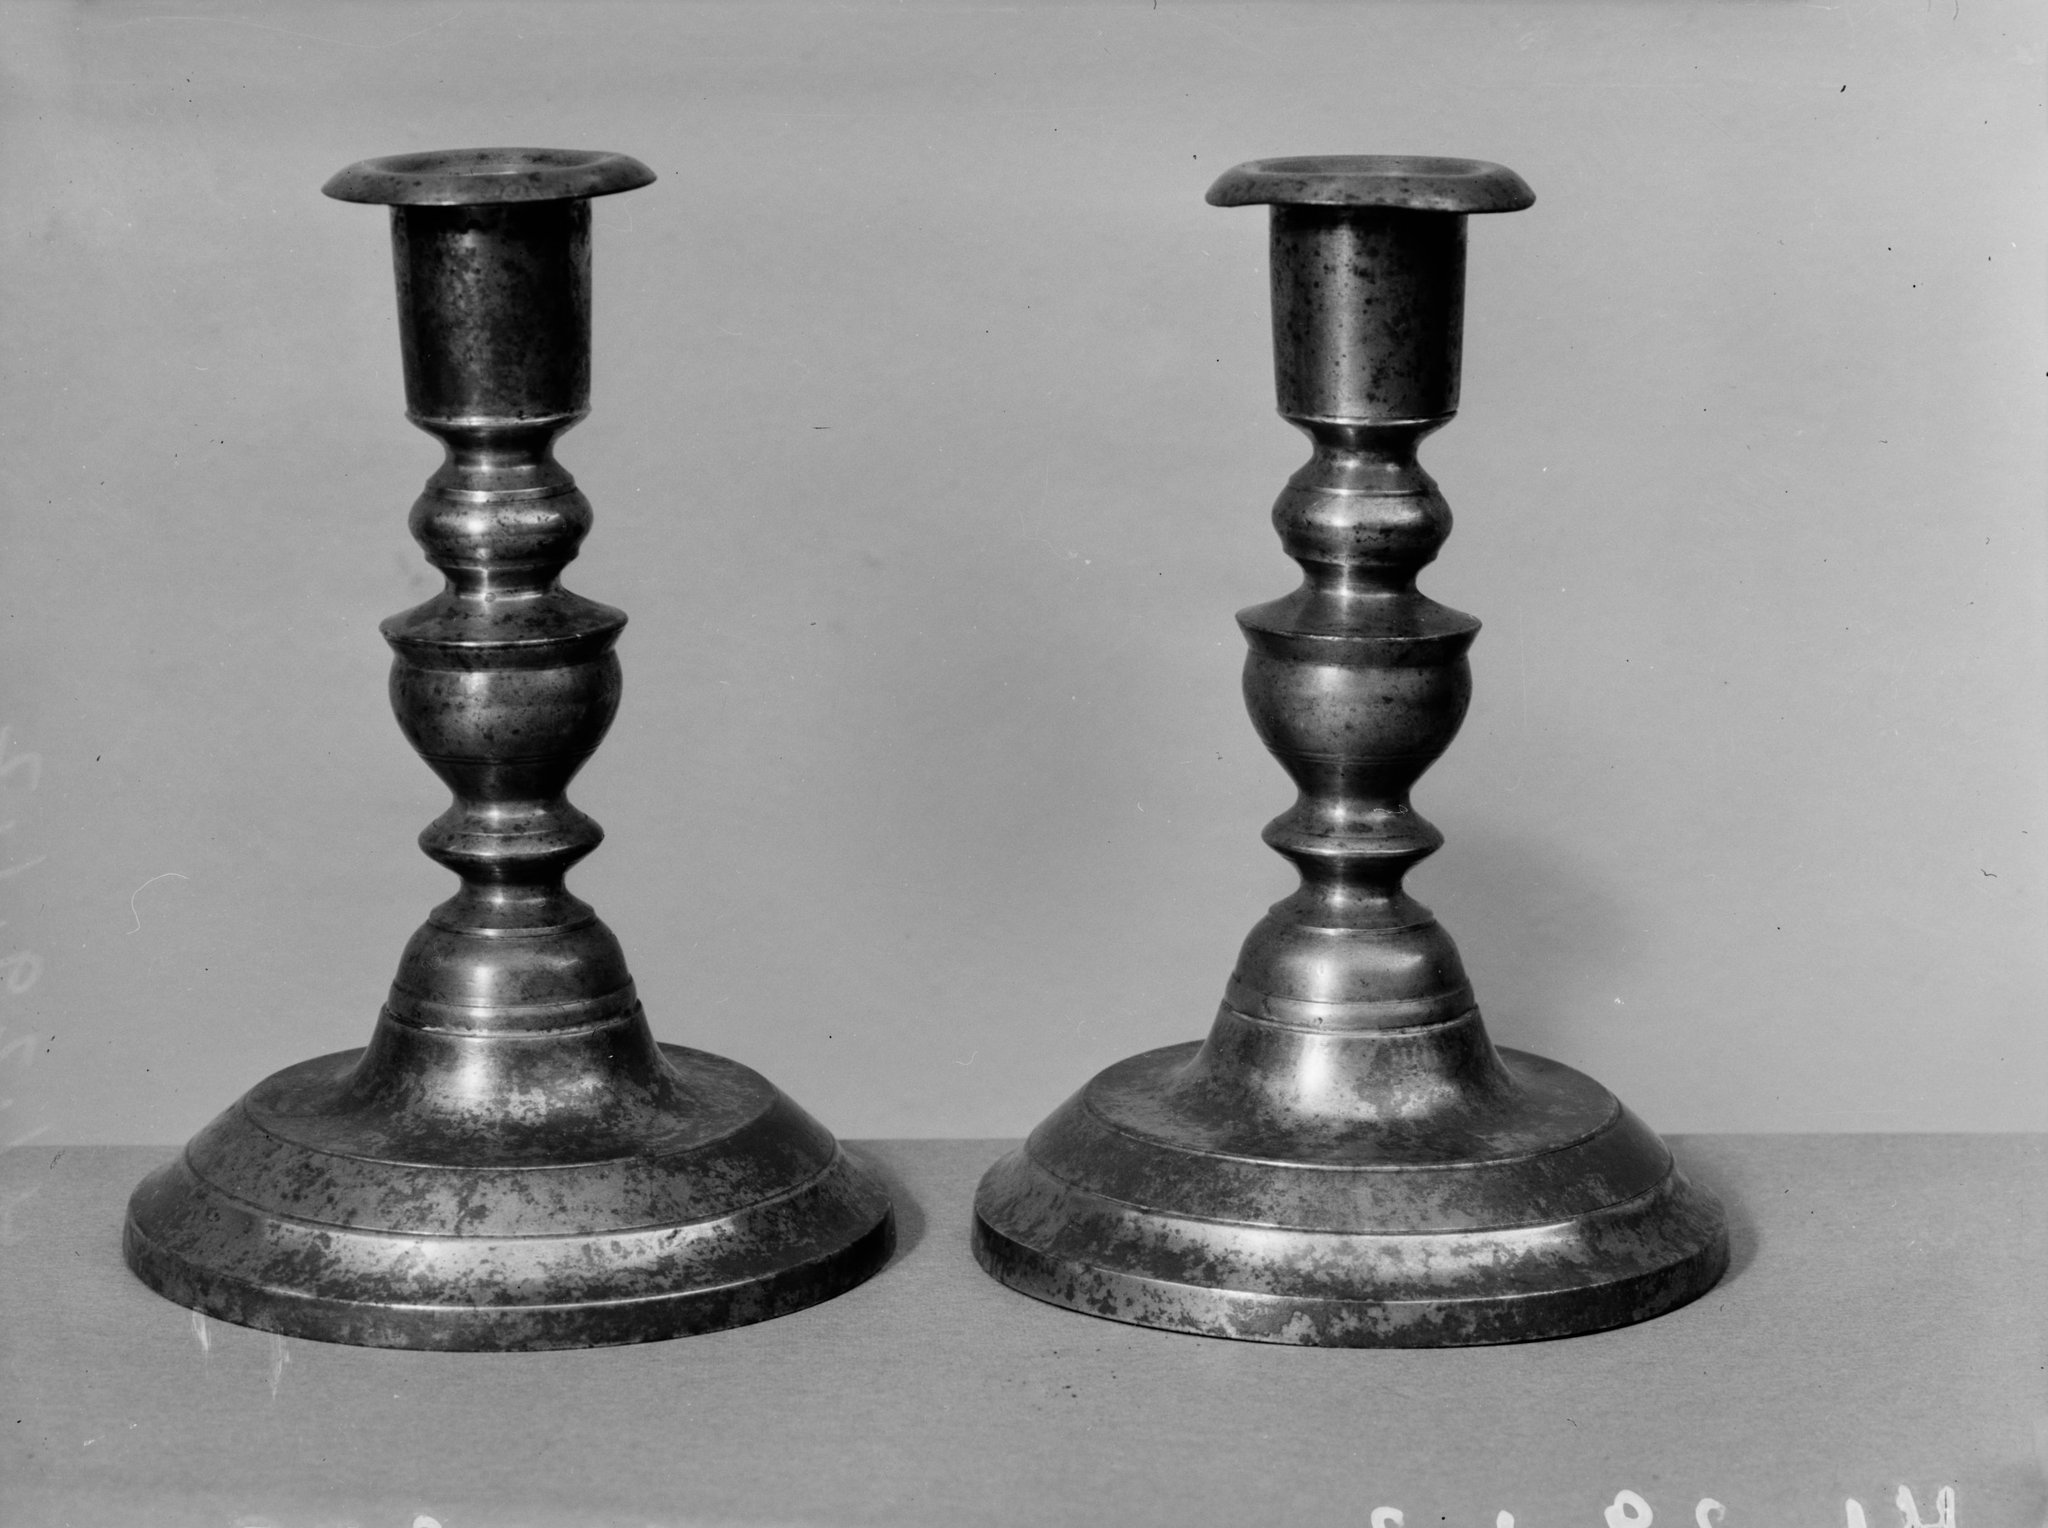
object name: candlestick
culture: american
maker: rufus dunham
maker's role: maker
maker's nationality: american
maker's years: 1815-1882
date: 1837-1860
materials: pewter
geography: united states